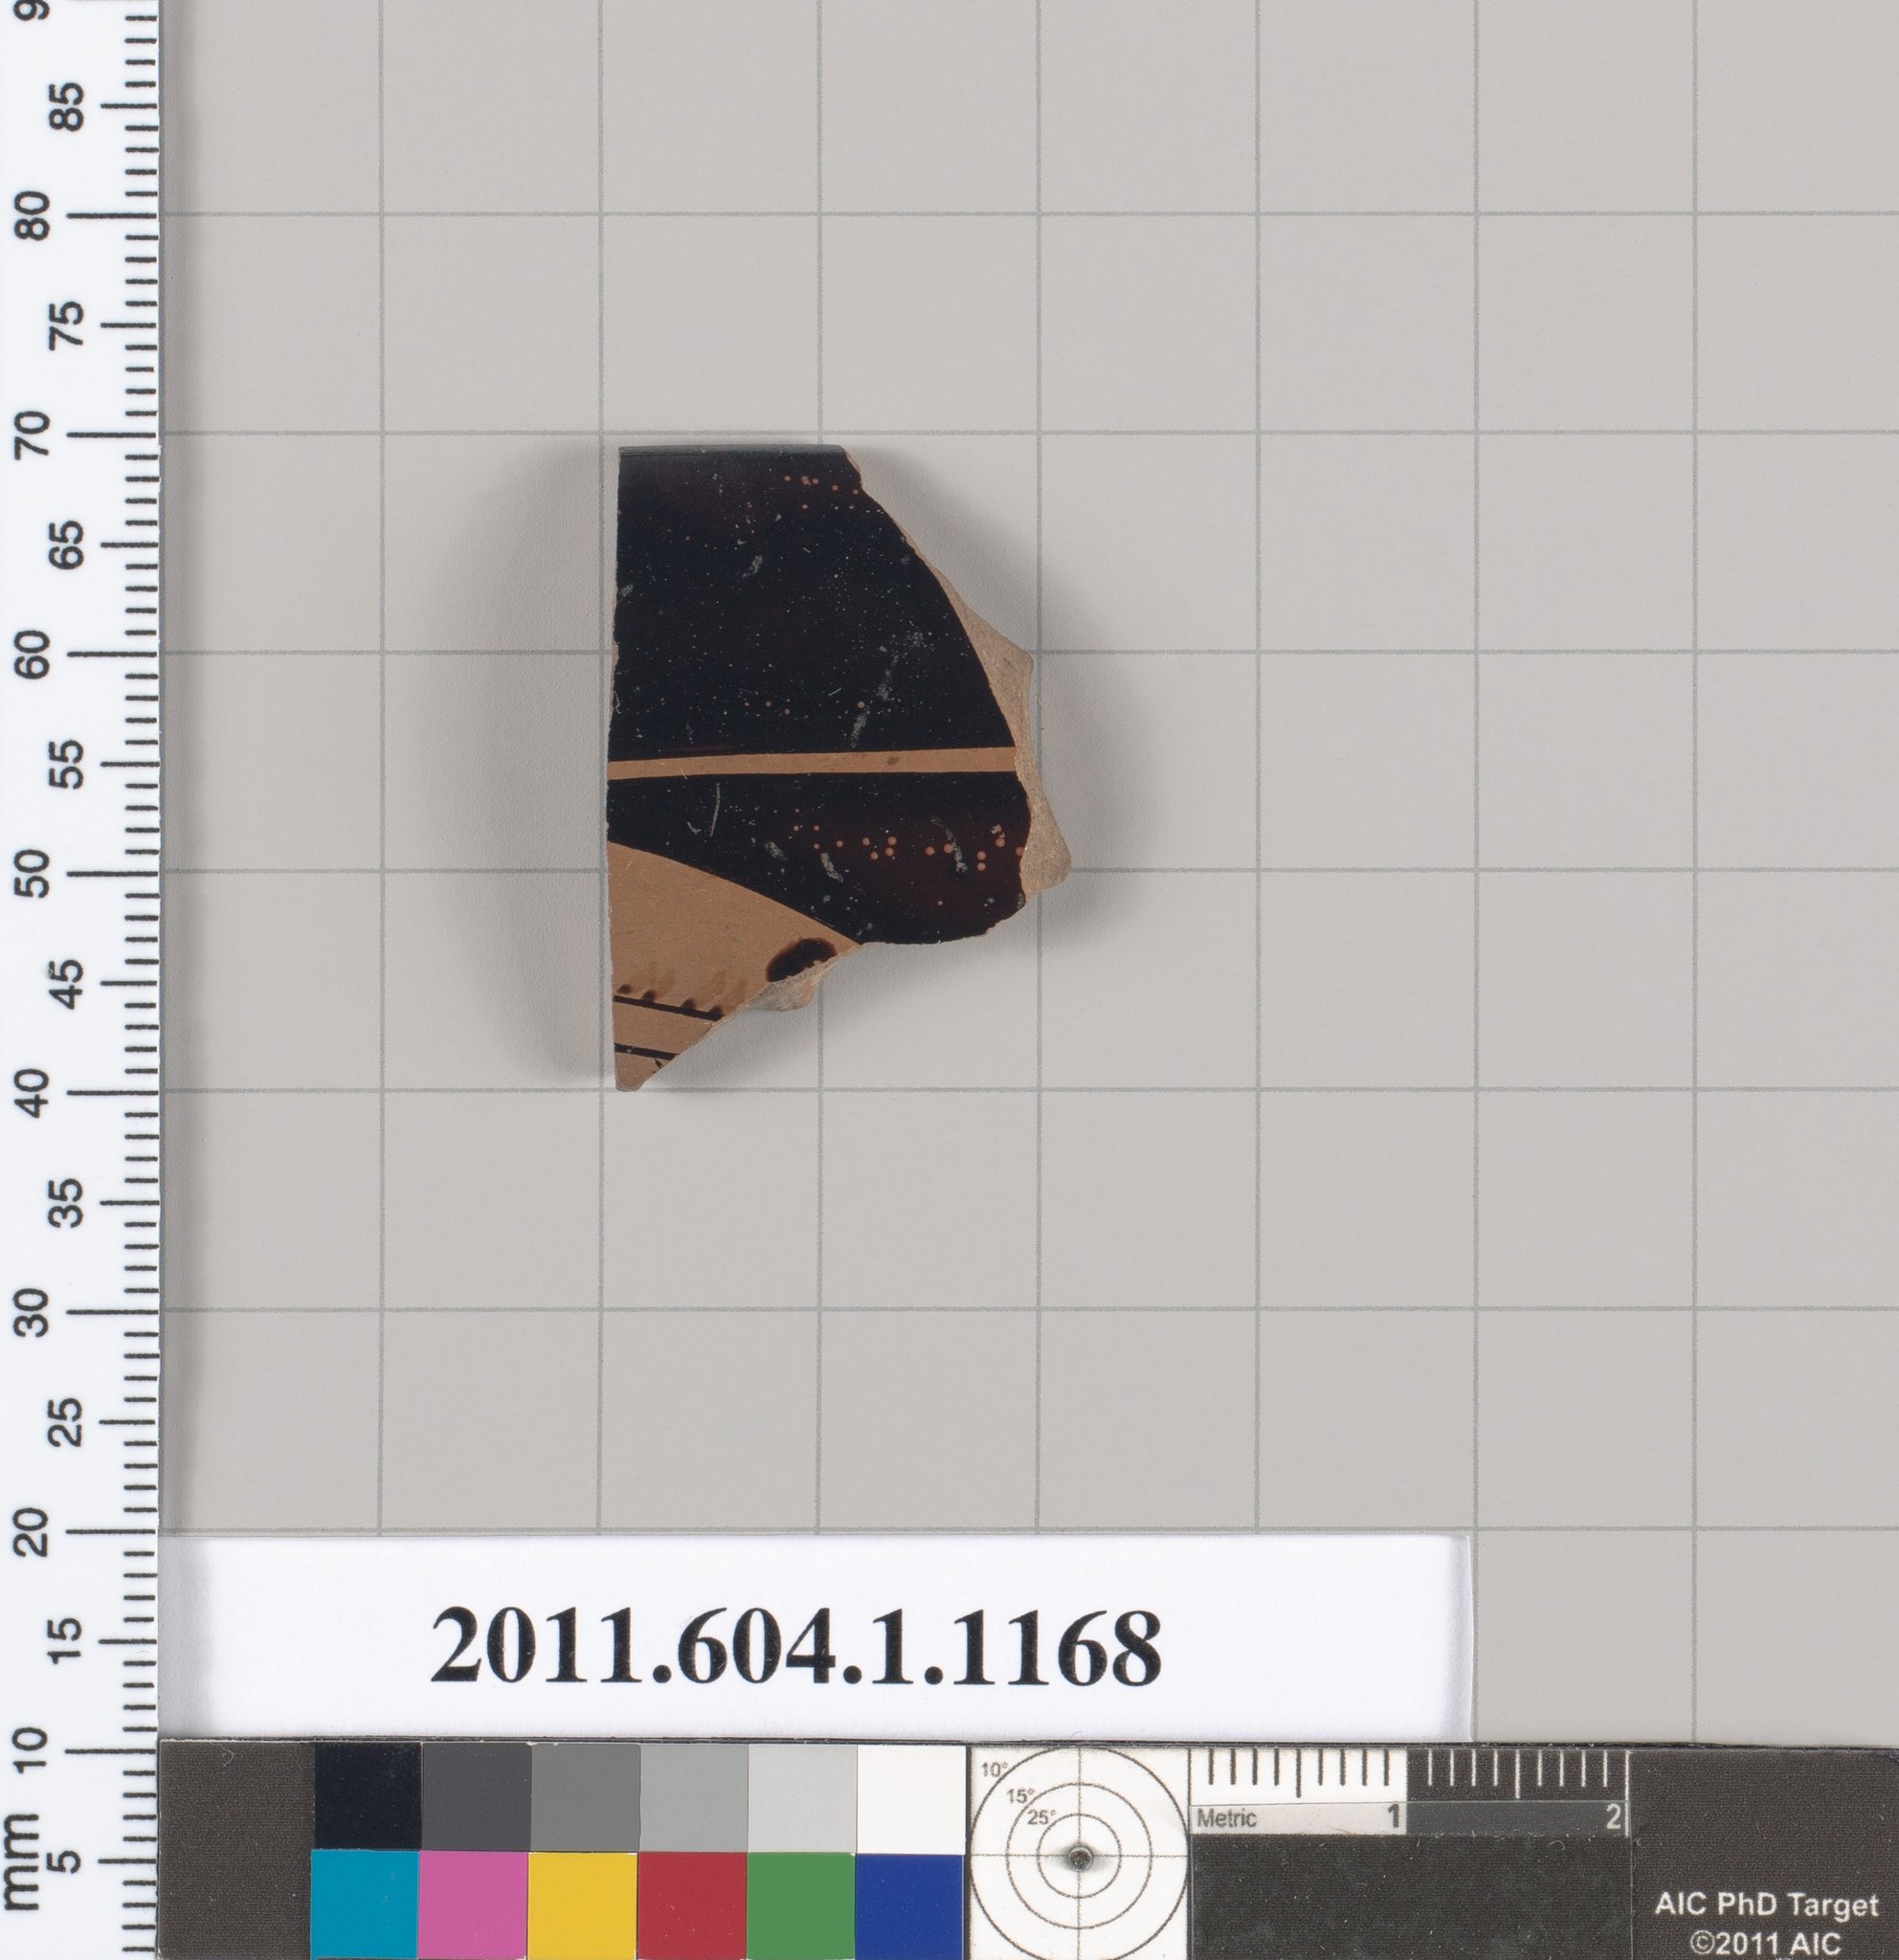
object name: kylix fragment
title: Terracotta rim fragment of a kylix (drinking cup)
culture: greek, attic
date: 490-480 BCE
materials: terracotta